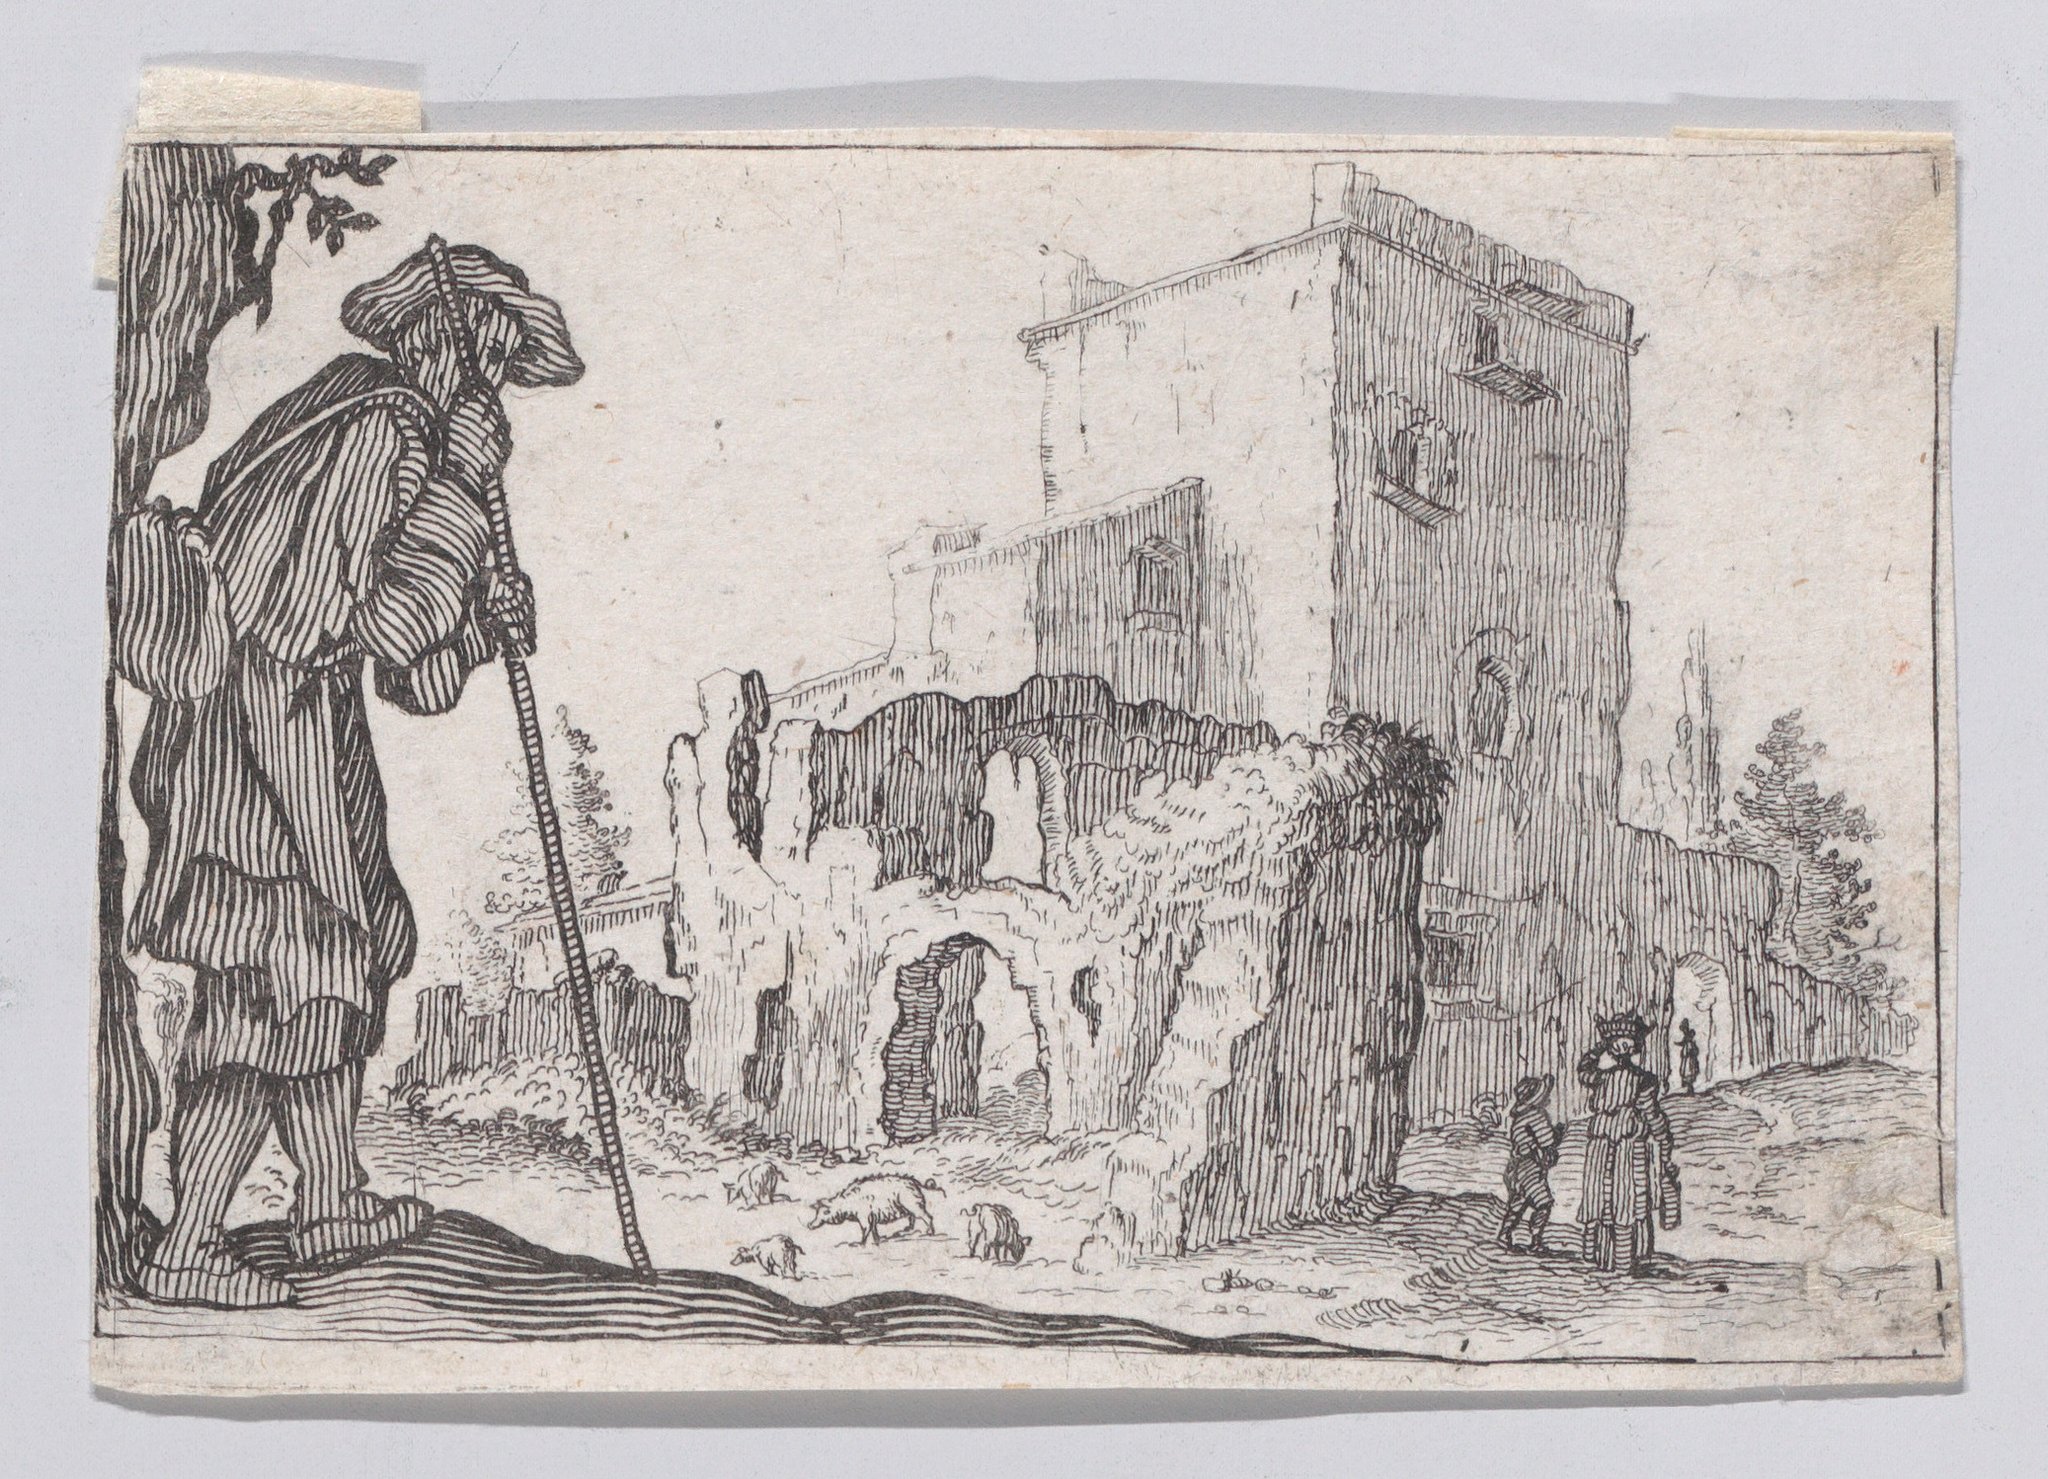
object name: print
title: Reverse Copy of Le Patre et les Ruines (The Shepherd and the Ruins), from "Les Caprices" Series A, The Florence Set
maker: Anonymous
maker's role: artist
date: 1601-1700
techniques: etching